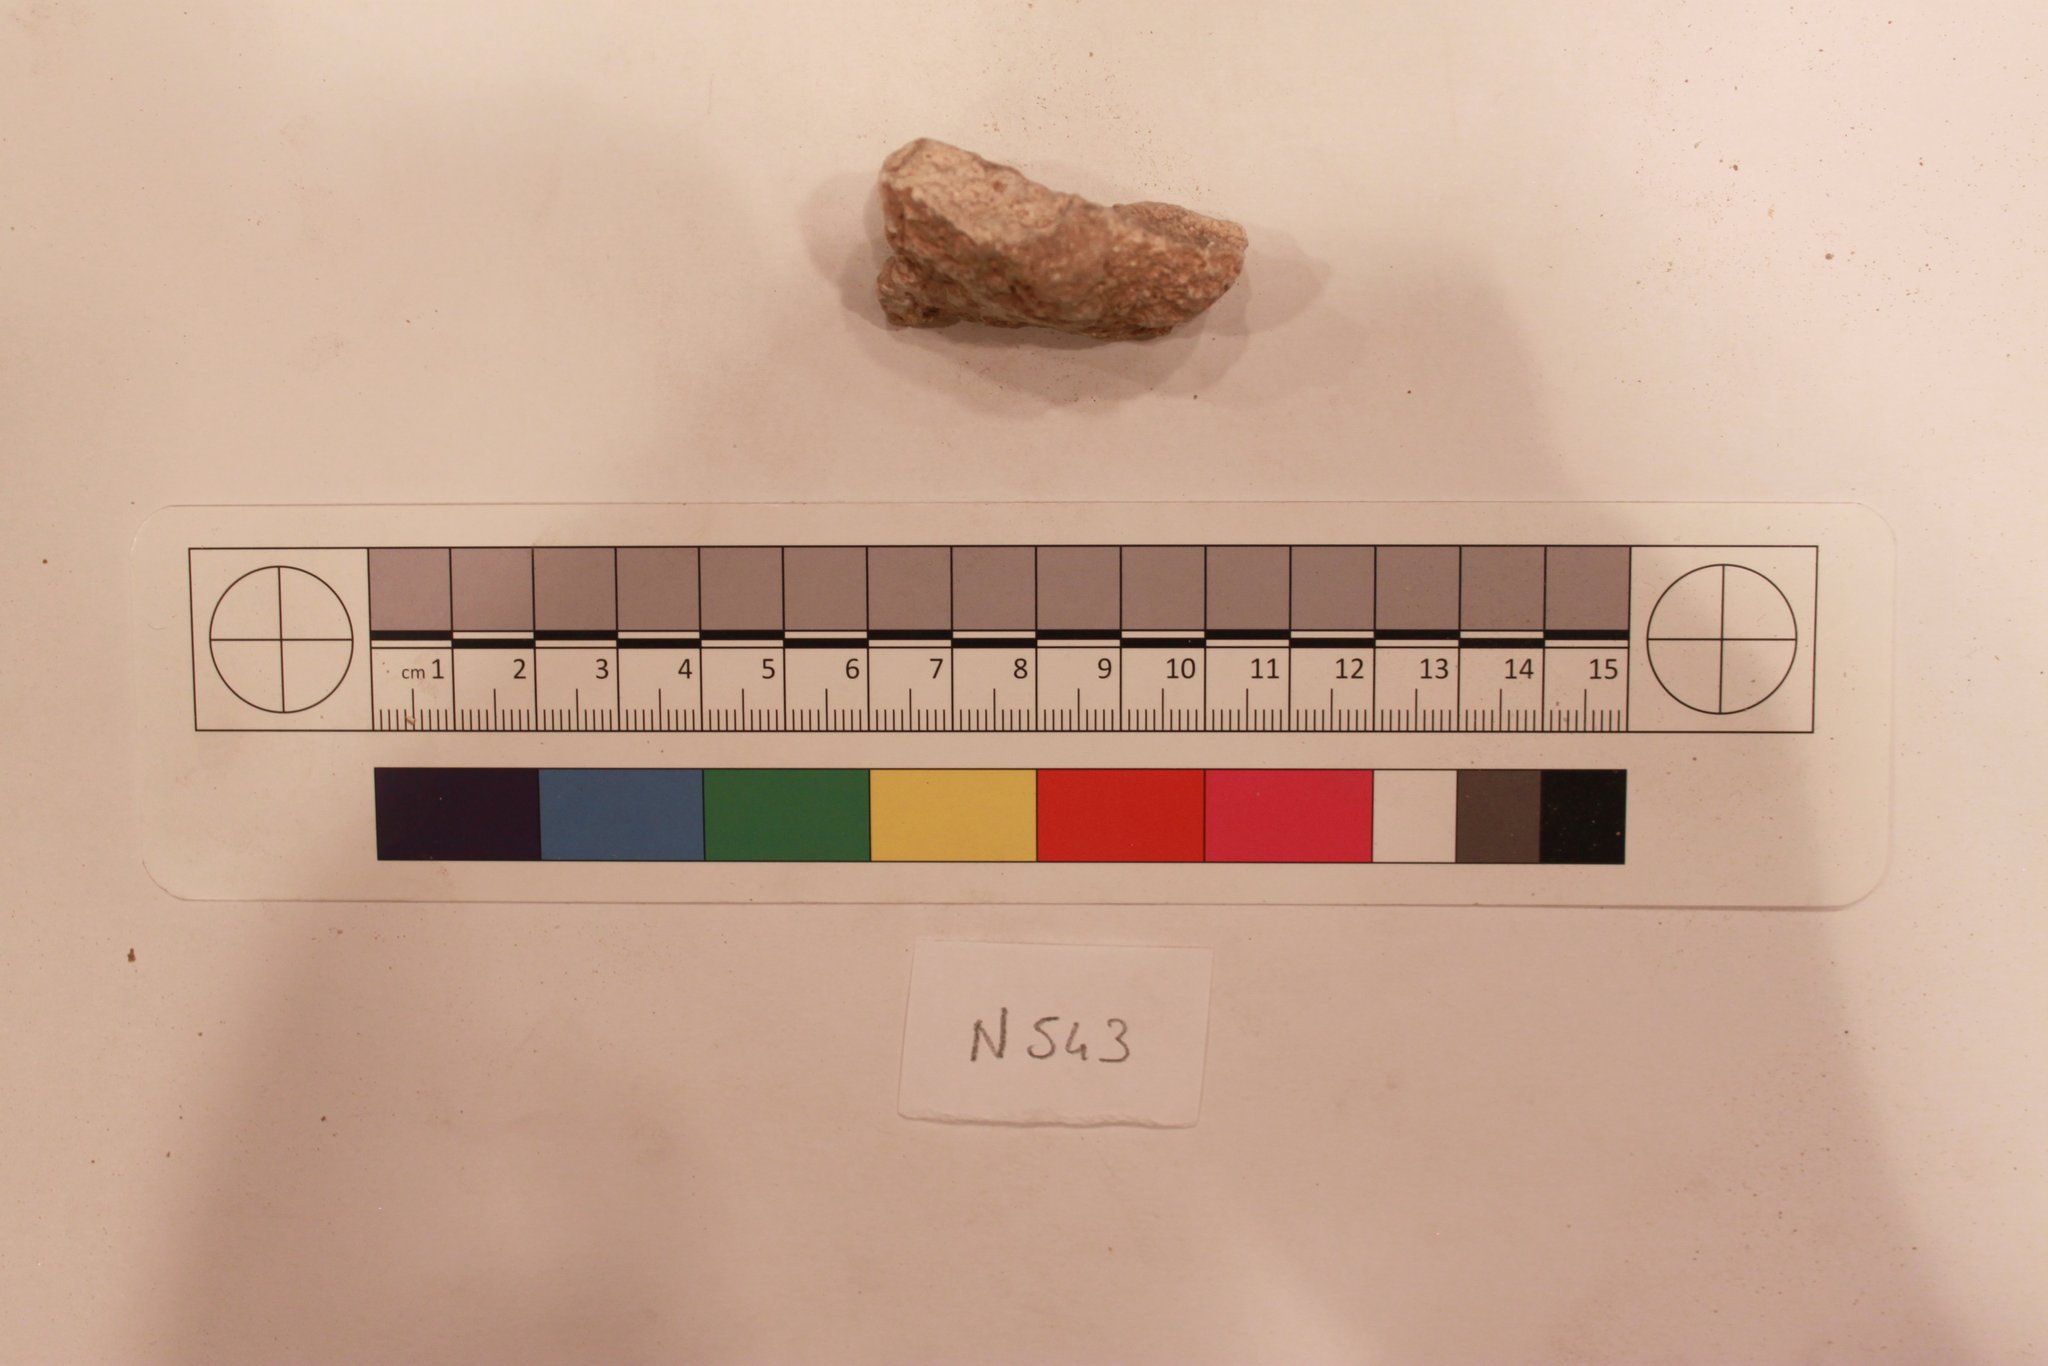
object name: fragment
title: Stucco Fragment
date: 701-1200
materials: plaster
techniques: carving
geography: iran